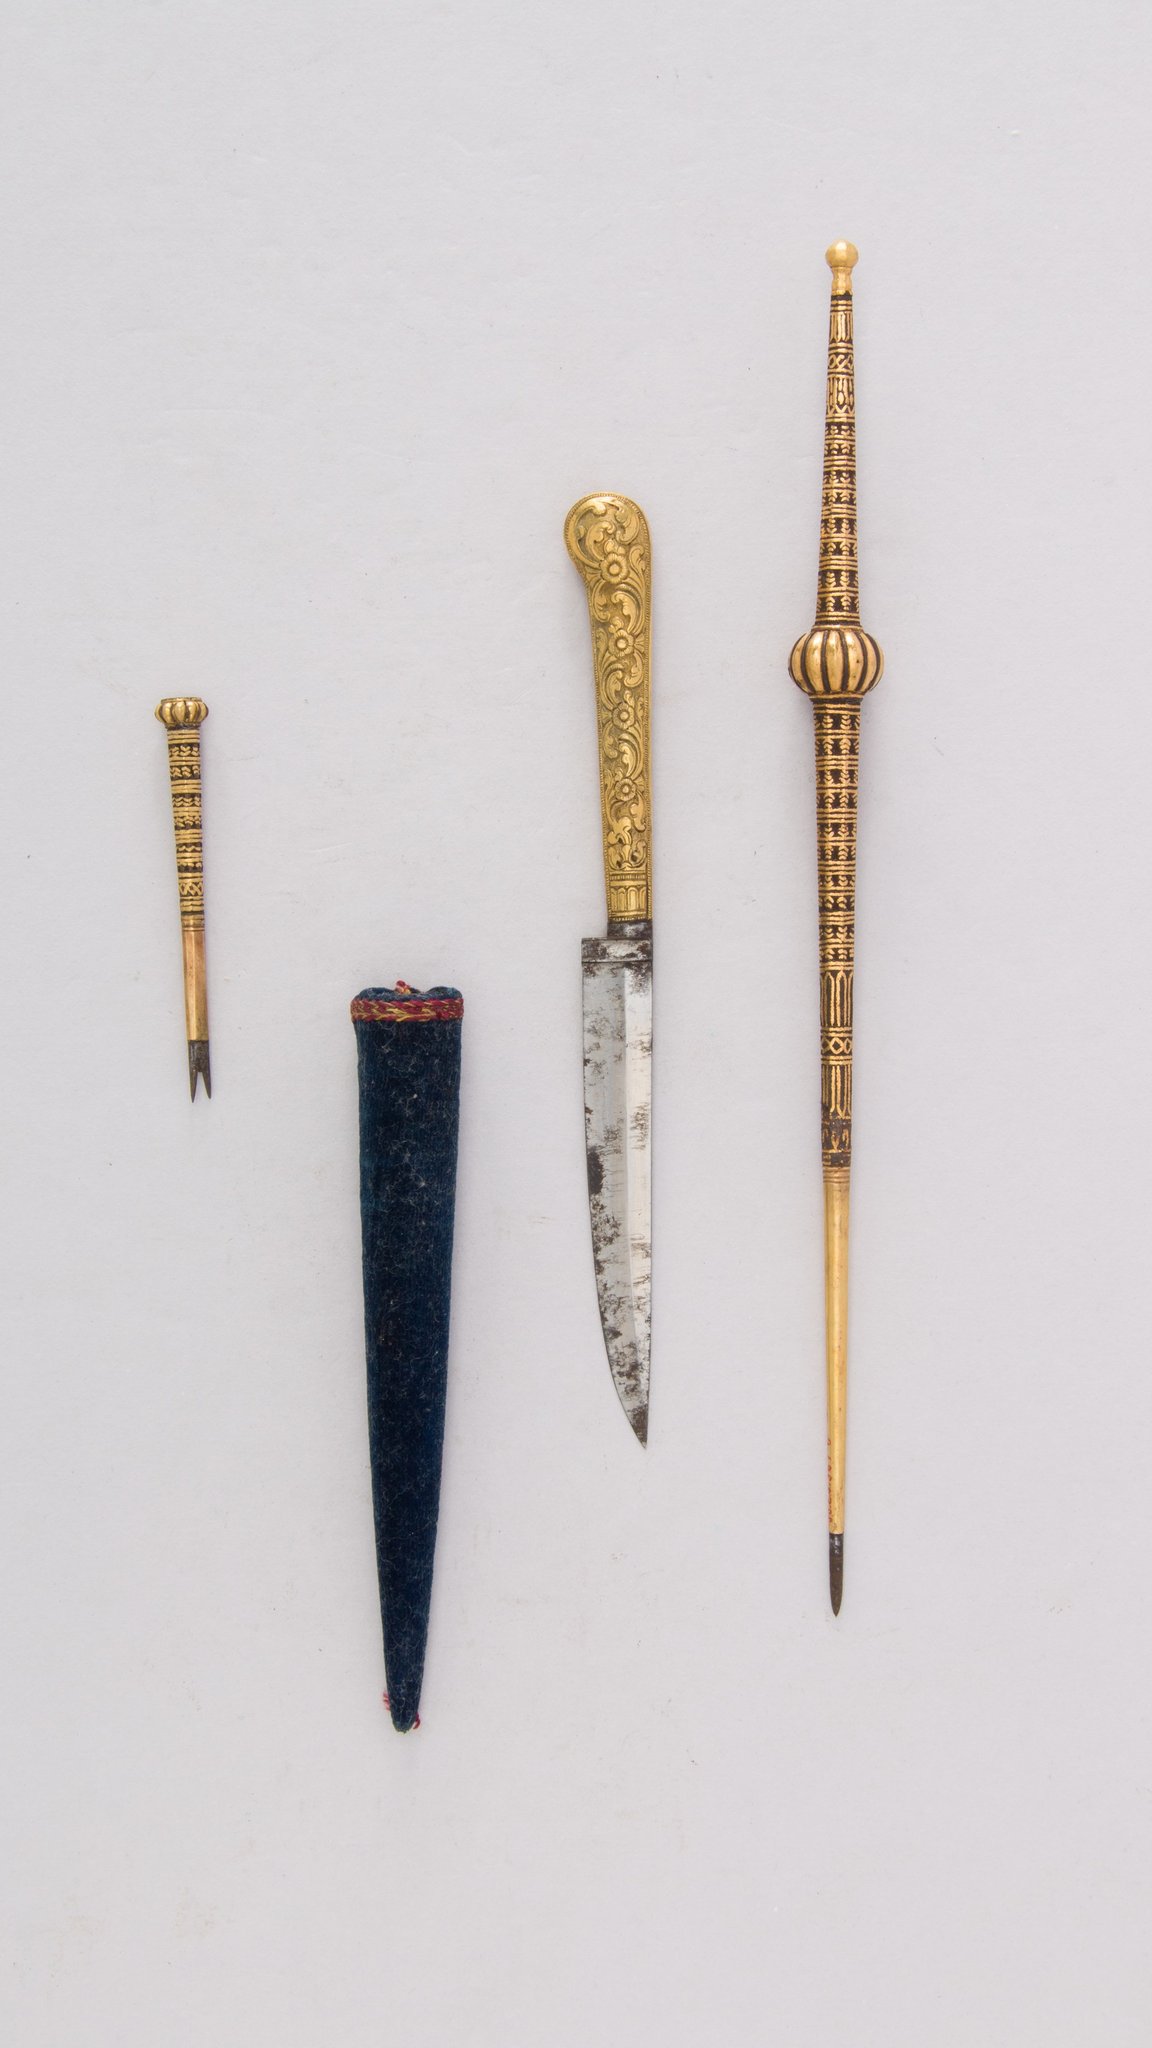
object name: knife piha kaetta with sheath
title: Knife (Piha Kaetta) with Stylus, Pricker, and Sheath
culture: sri lankan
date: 1701-1900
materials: gold, steel, velvet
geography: sri lanka